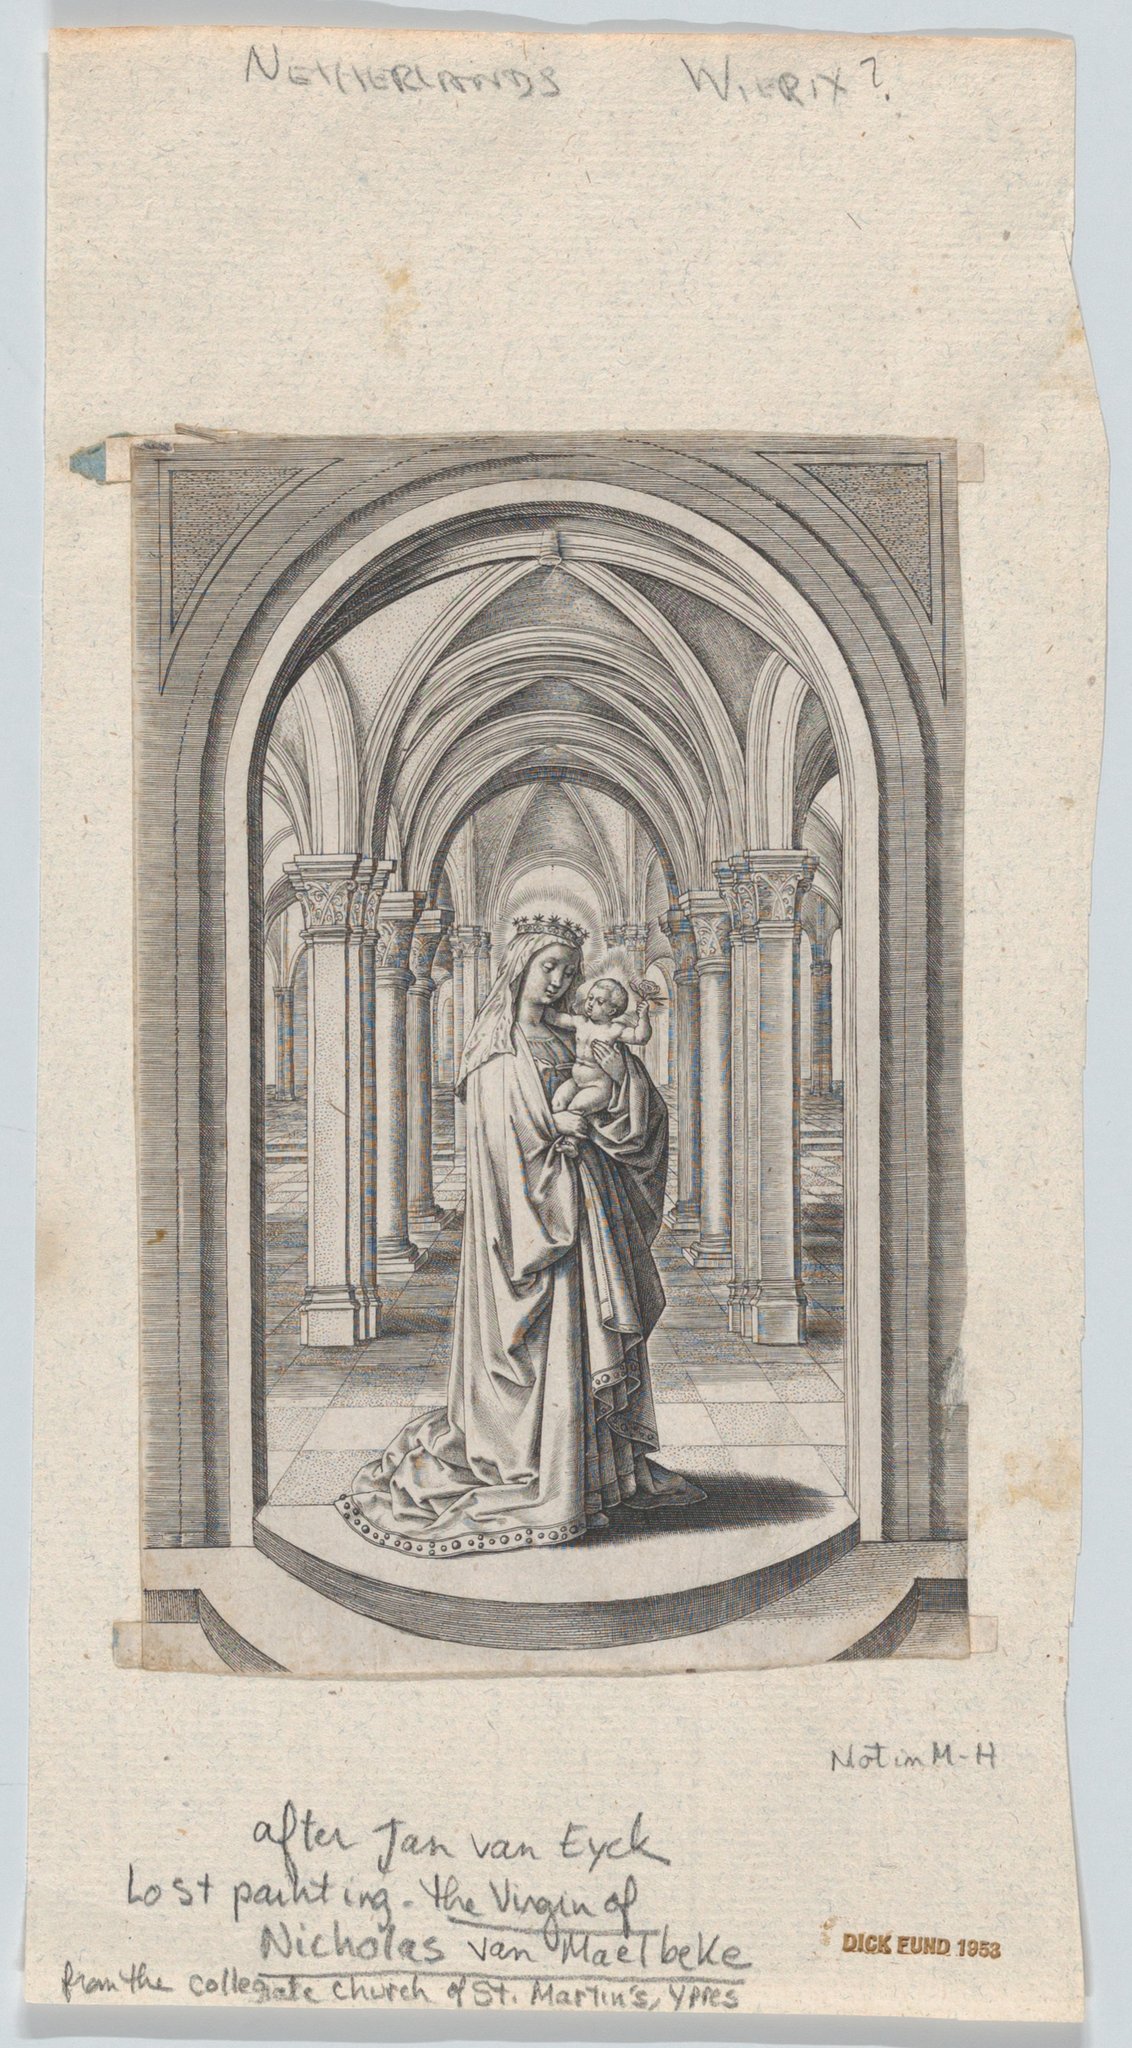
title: Virgin and Child in a Church, also known as the Van Maelbeke Virgin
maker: wierix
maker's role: artist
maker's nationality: netherlandish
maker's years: 1550-1620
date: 1575-1585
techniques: engraving